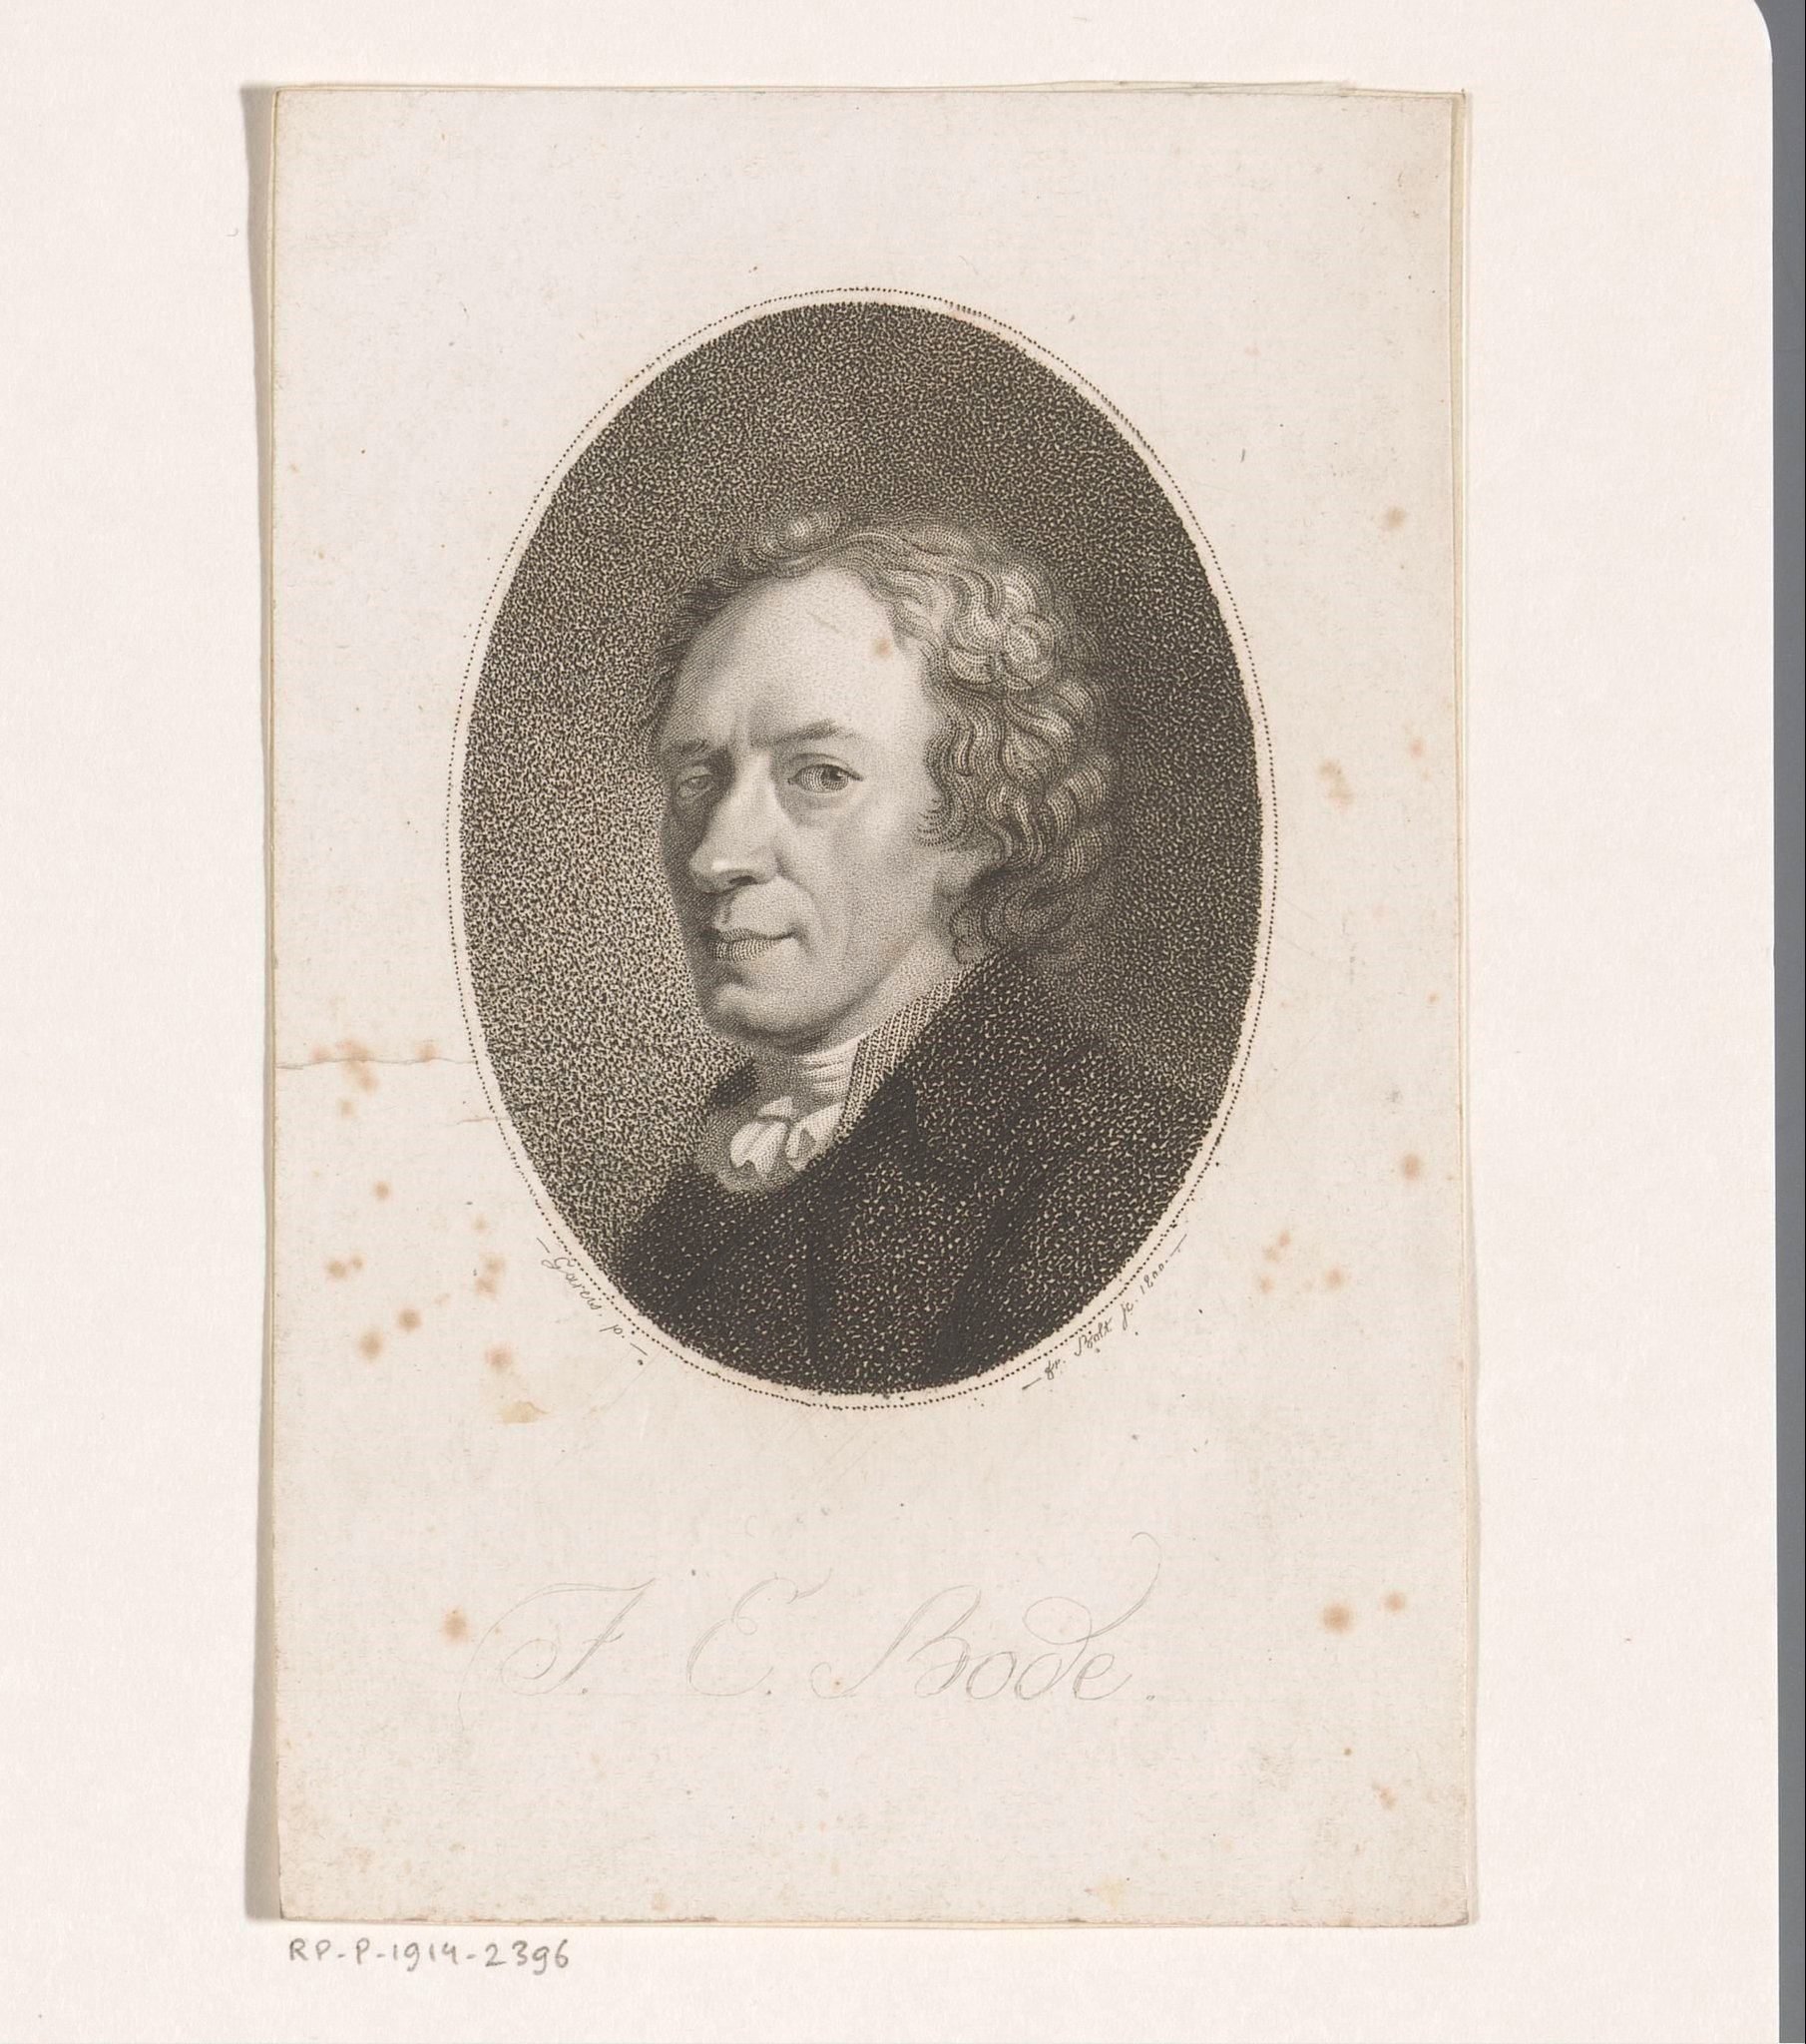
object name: print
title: Portret van Johann Elert Bode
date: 1800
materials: paper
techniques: stippling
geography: berlin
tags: berlin, historical persons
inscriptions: collector's mark: Lugt 2228